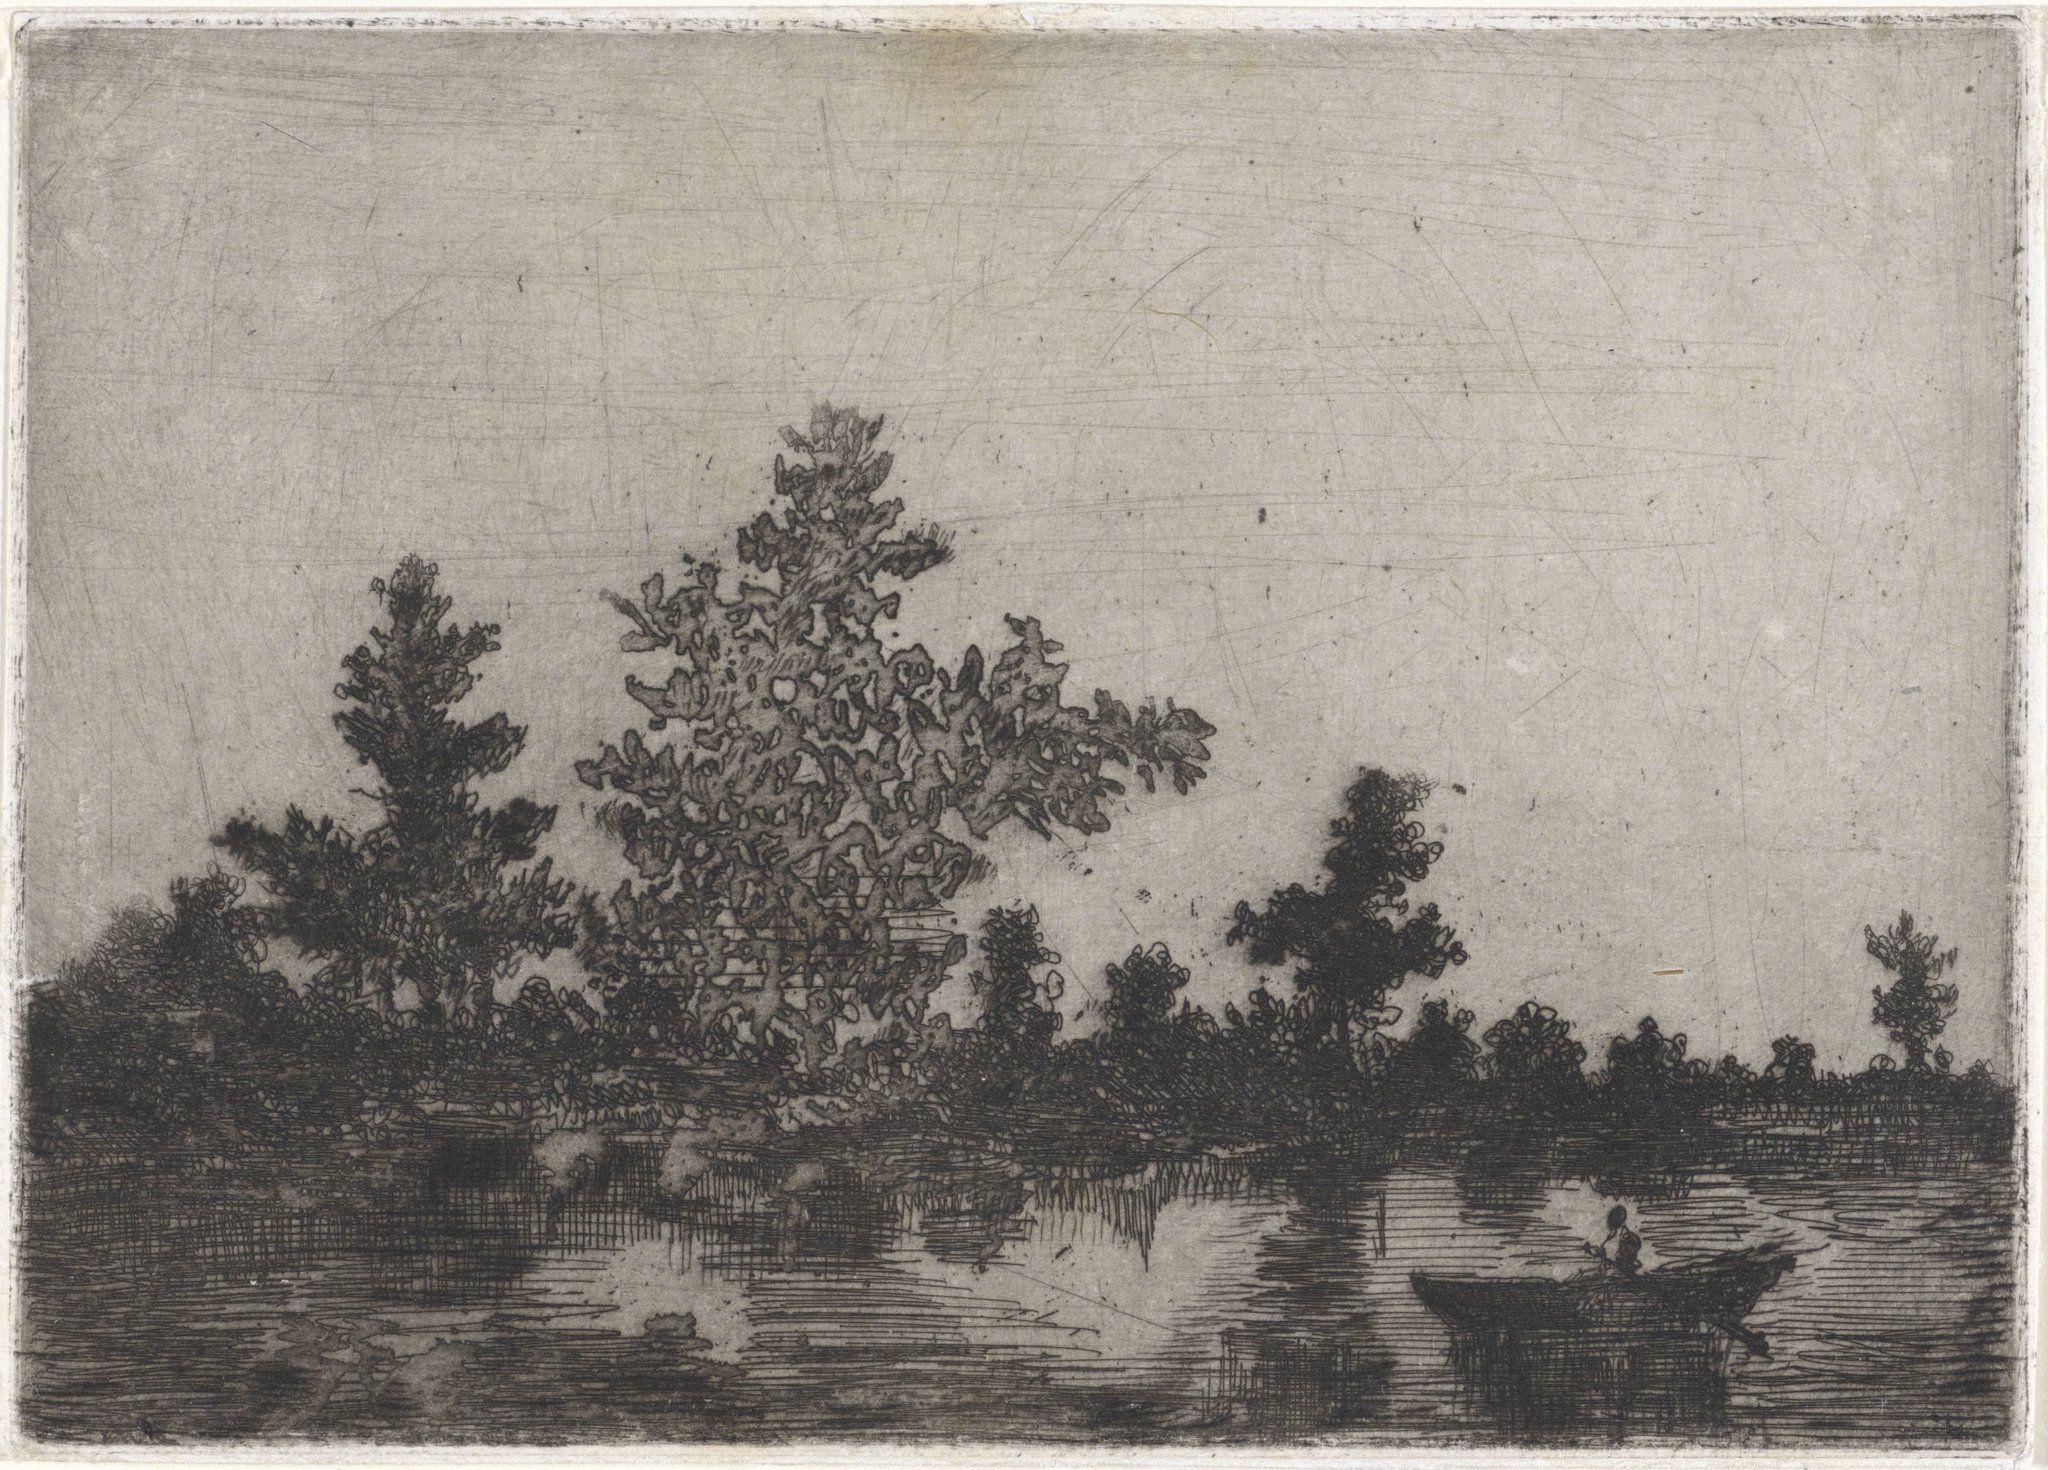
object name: print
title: Waterlandschap met roeiboot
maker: arnoud schaepkens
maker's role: print maker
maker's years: 1816-1904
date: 1831-1904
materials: paper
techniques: drypoint, etching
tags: landscapes with waters, waterscapes, seascapes (in the temperate zone), rowing-boat, canoe, etc.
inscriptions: collector's mark: Lugt 2228